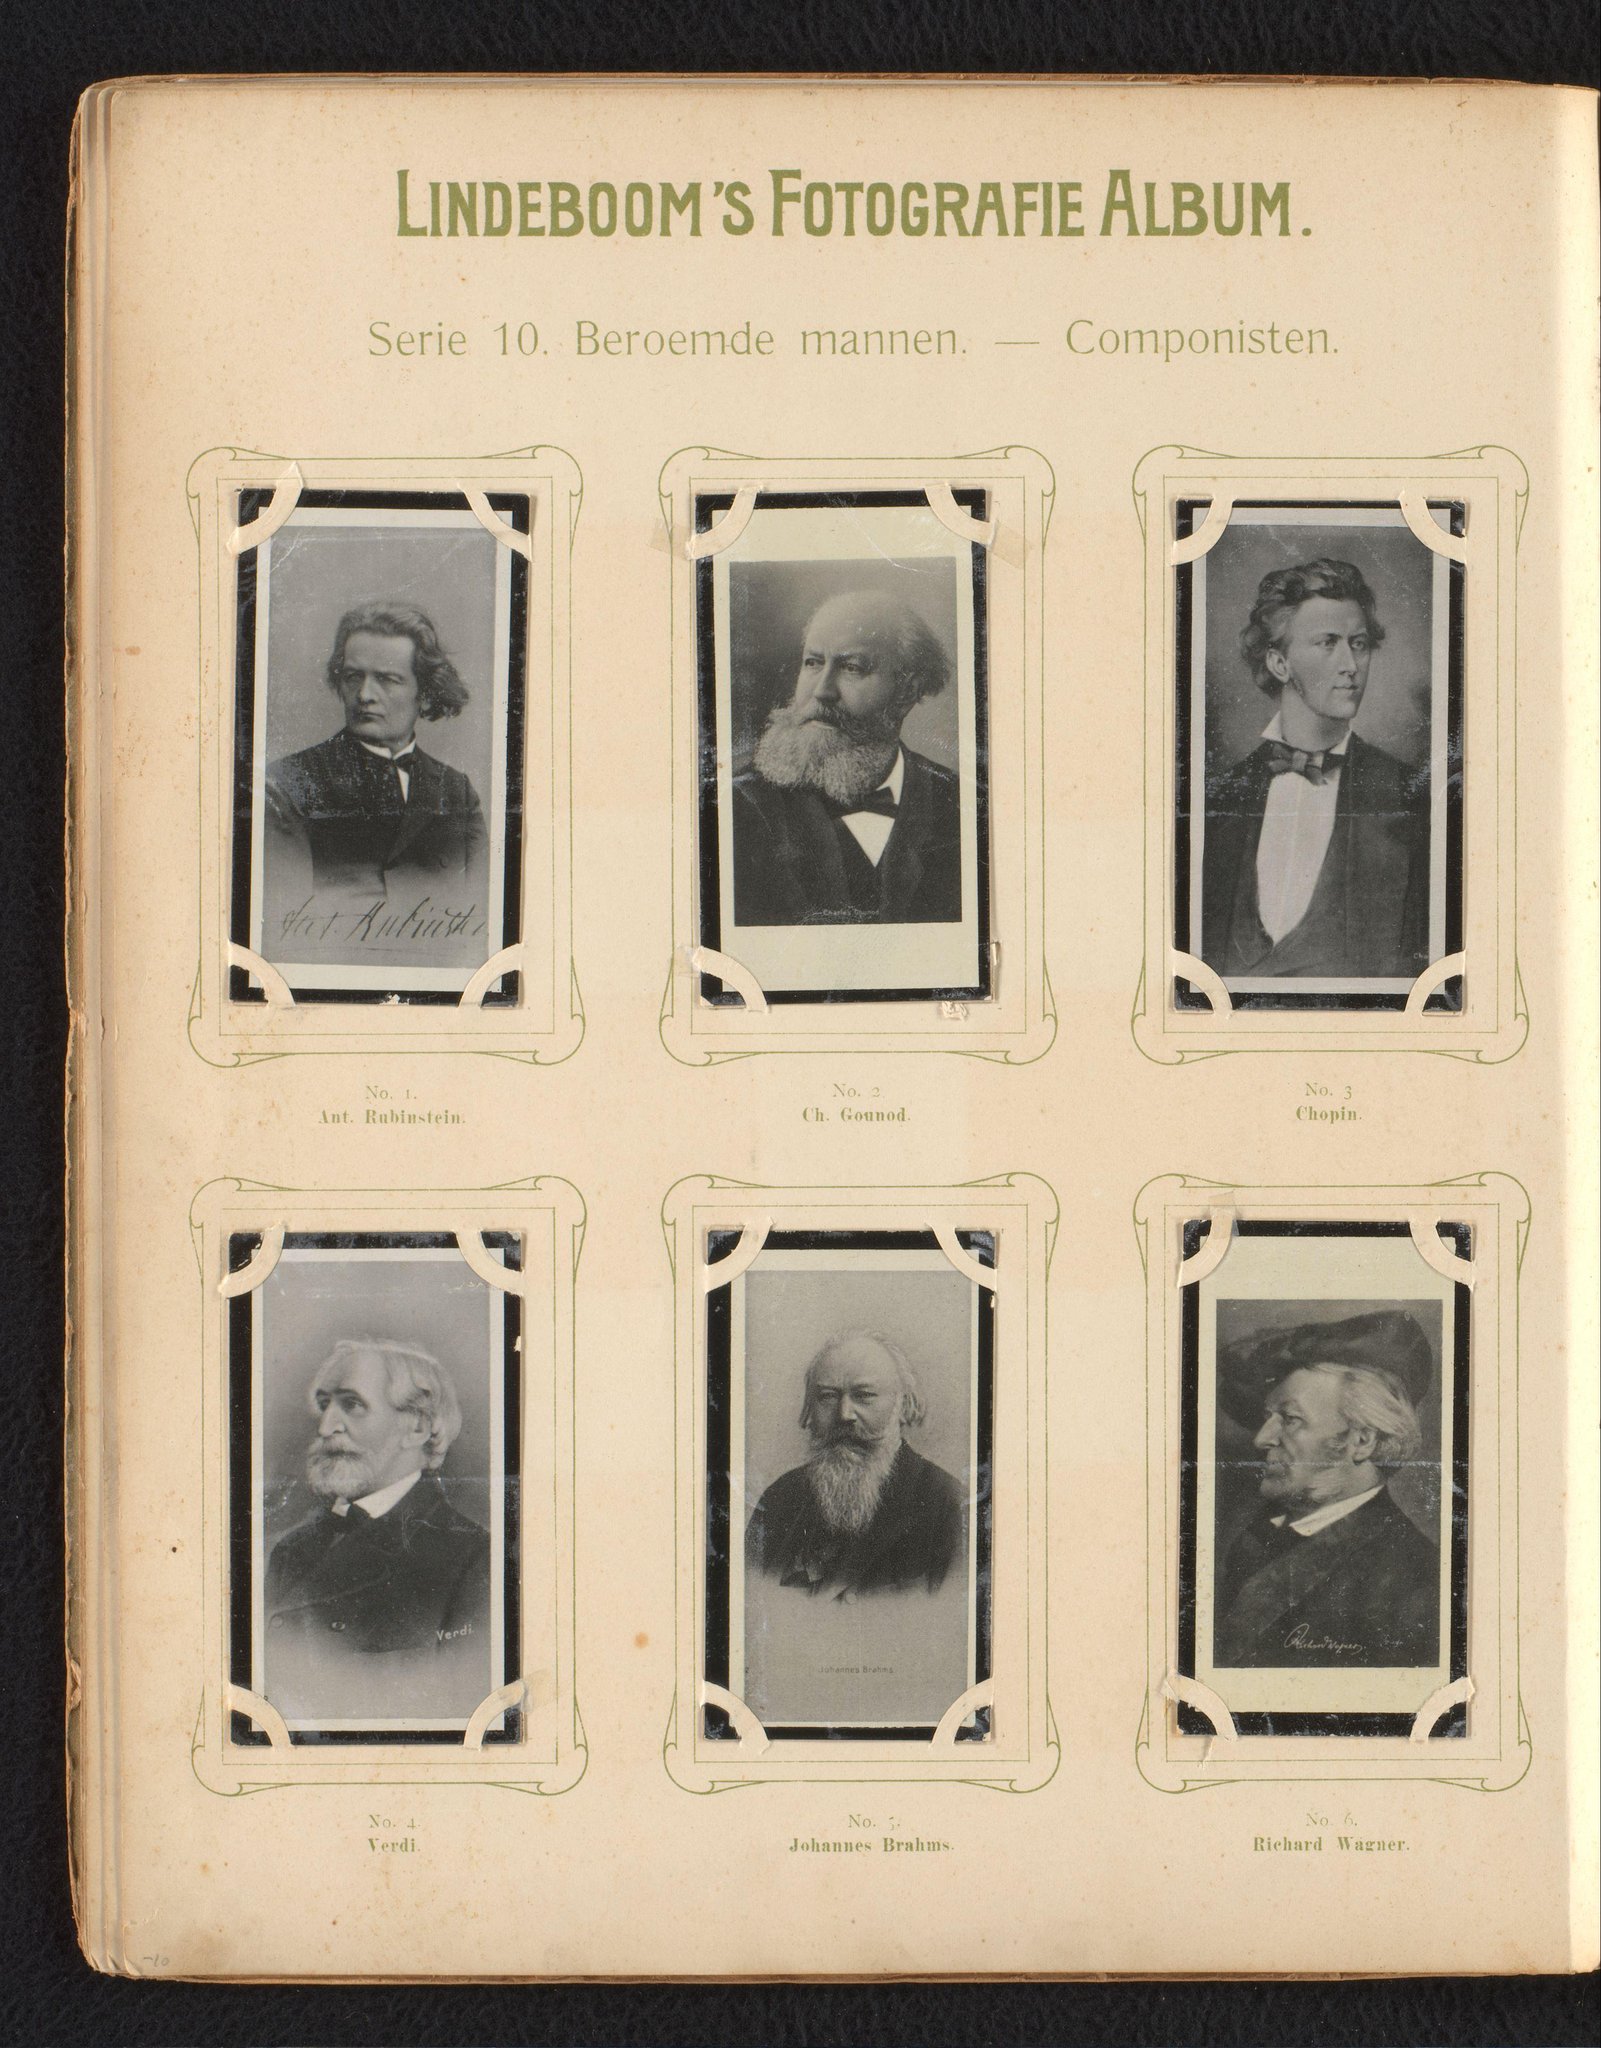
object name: album leaf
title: Zes reproducties van geschilderde en fotografische portretten van Anton Rubinstein, Charles Gounod, Frédéric Chopin, Giuseppe Verdi, Johannes Brahms en Richard Wagner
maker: Anonymous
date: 1905-1906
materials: cardboard, paper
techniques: photograph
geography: amsterdam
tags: richard wagner, vienna, johannes brahms, charles gounod, historical persons, portrait of composer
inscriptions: inscription: ‘Serie 10.’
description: Dergelijke prenten stonden bekend als 'zwartjes'. Men verkreeg ze bij aanschaf van bepaalde merken thee, cacao, sigaretten, beschuit, etc. om te verzamelen. Er waren speciaal voor de 'zwartjes' vervaardigde verzamelalbums in omloop.